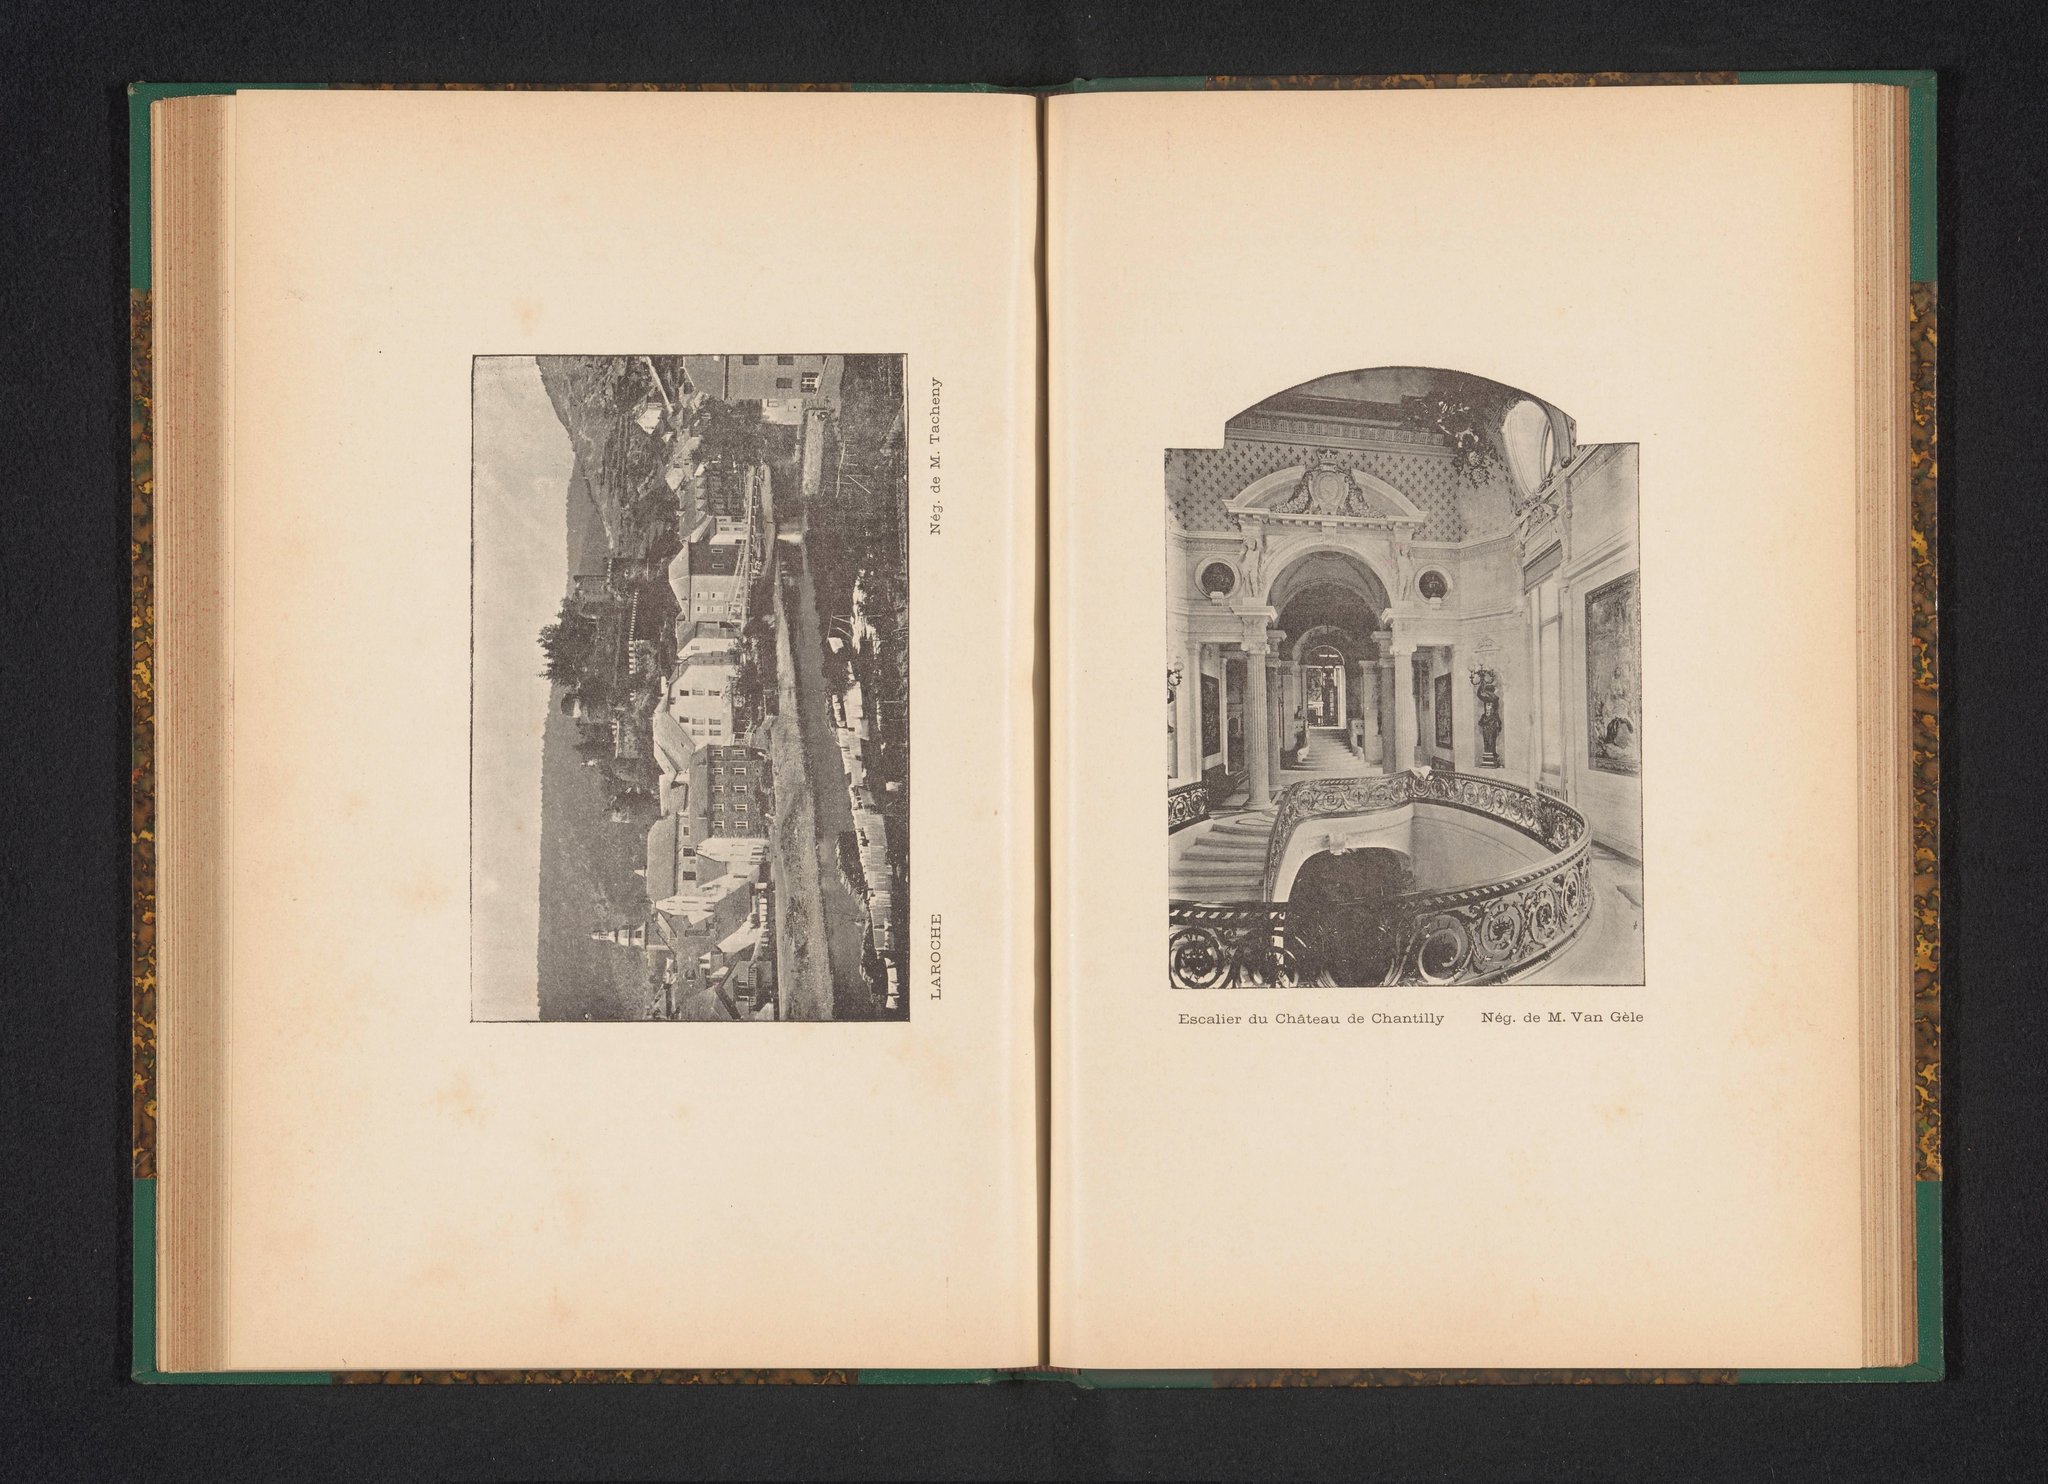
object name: photomechanical print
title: Gezicht op La Roche-en-Ardenne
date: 1896-1900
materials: paper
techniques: autotype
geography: la roche-en-ardenne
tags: city-view in general; 'veduta'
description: Prent op tweede ongenummerde pagina na pagina 160.